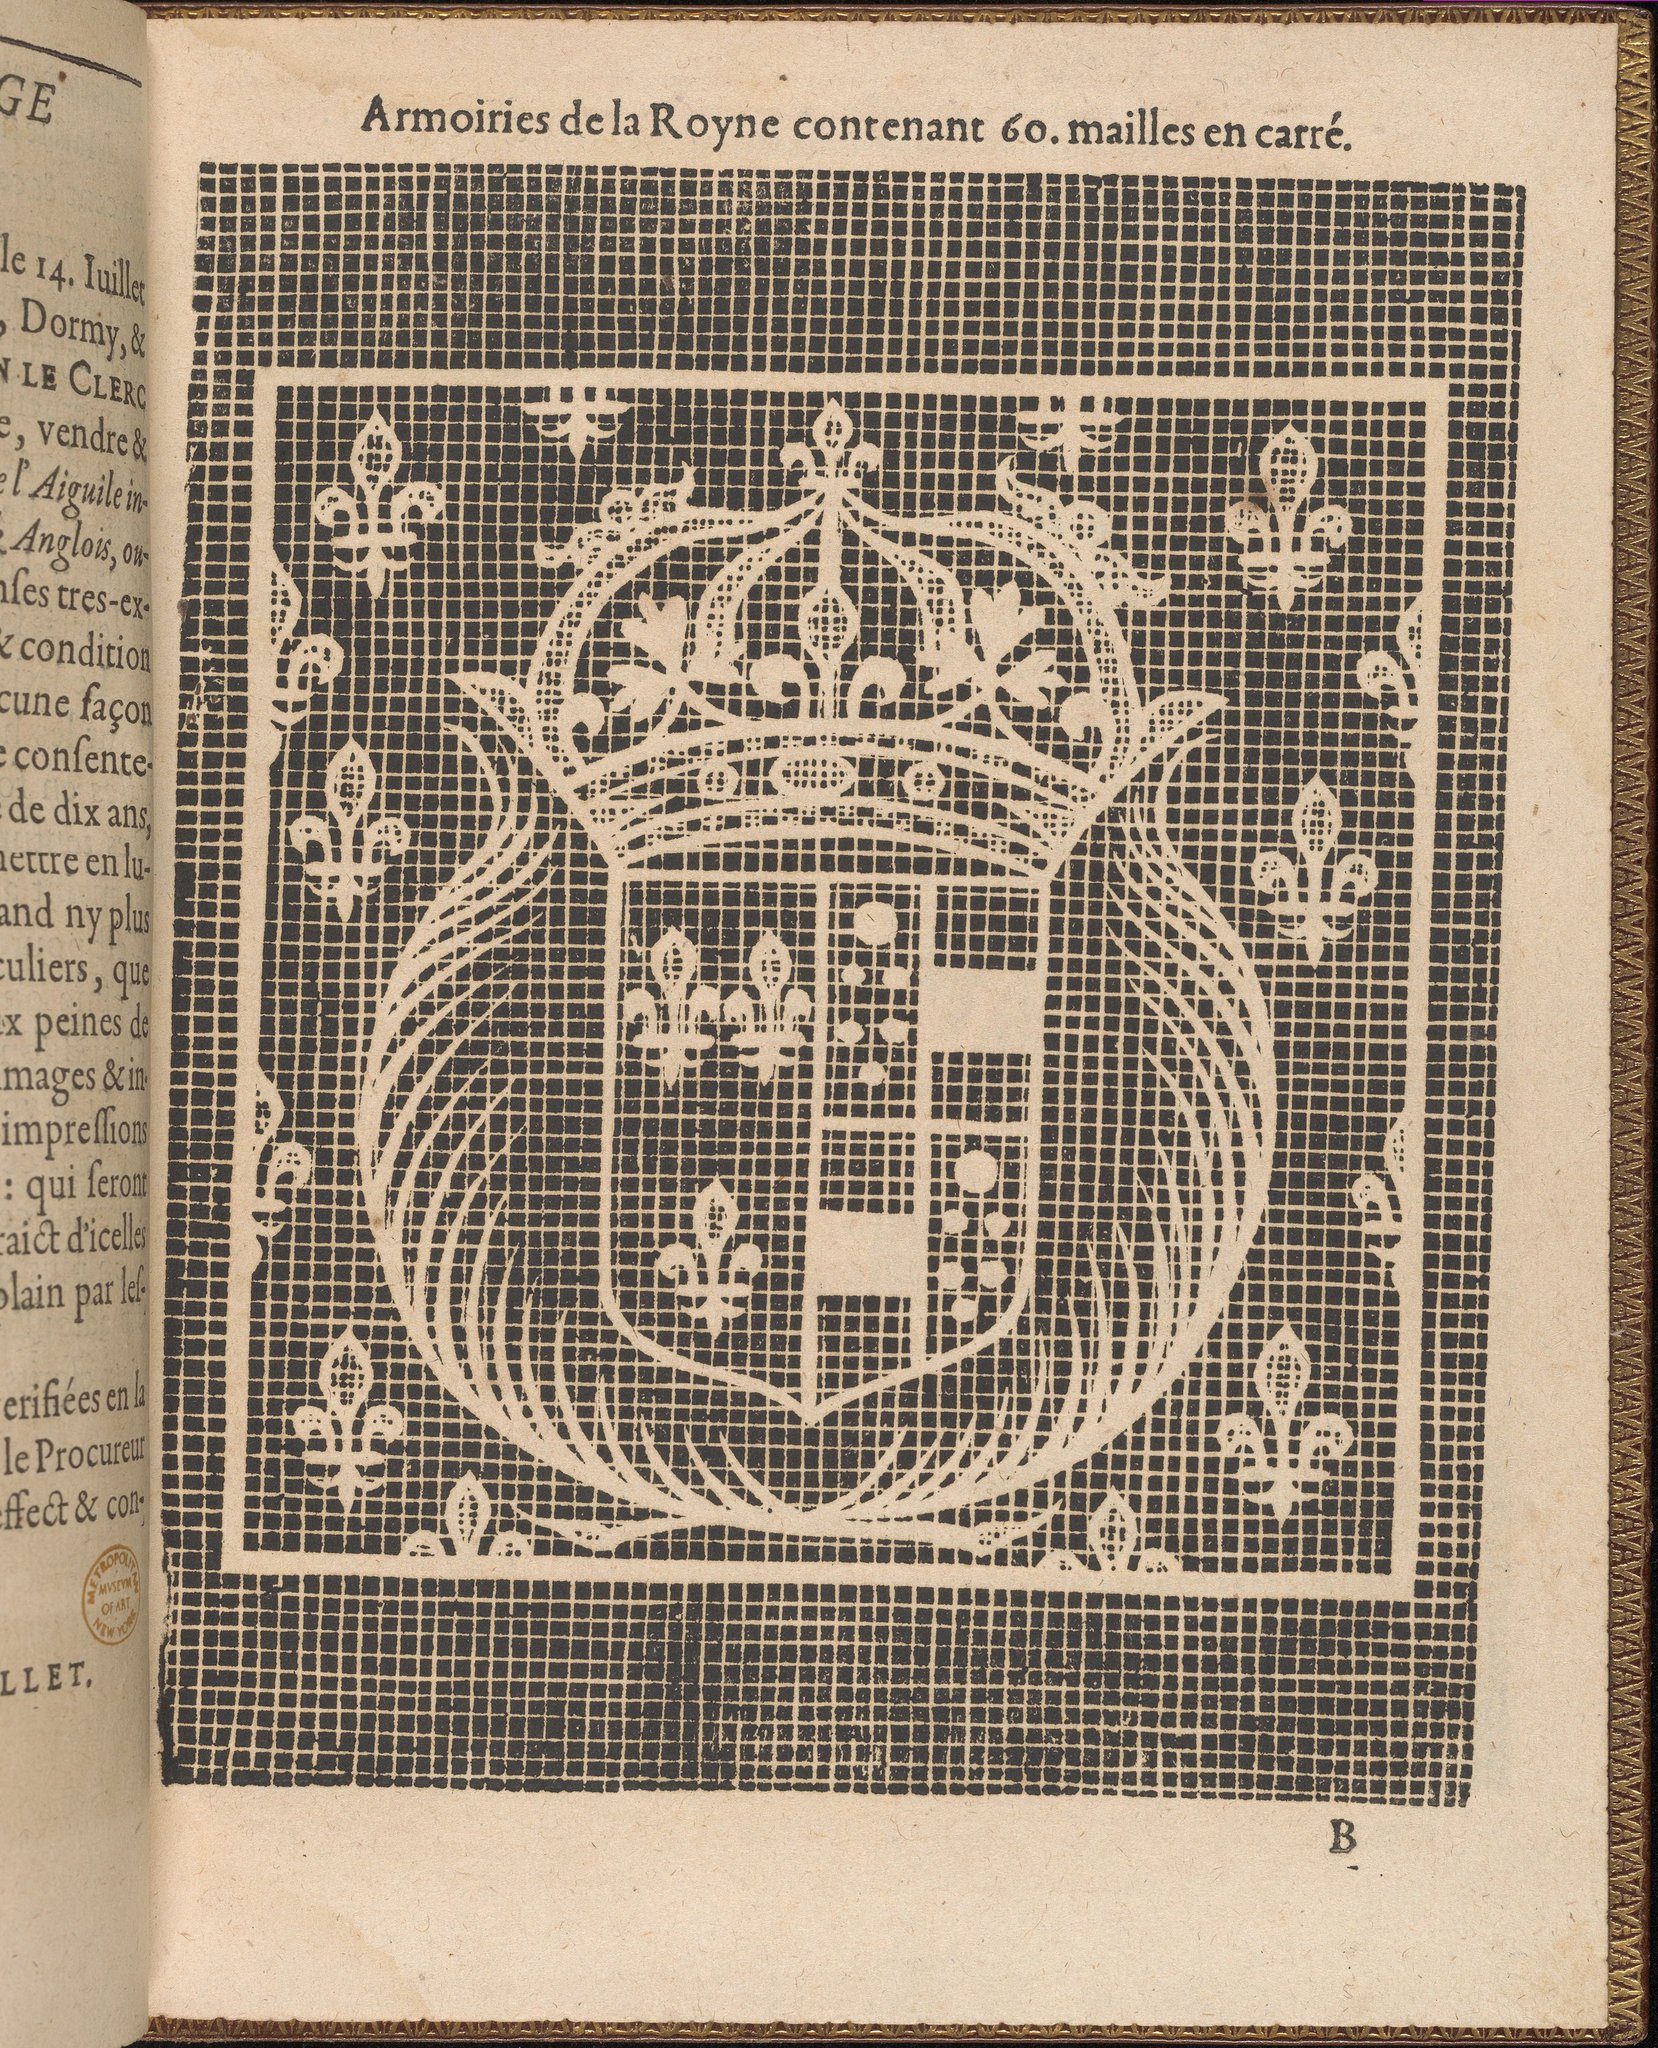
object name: book print ornament architecture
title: La Pratique de l'Aiguille, page 5 (recto)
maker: matthias mignerak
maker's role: author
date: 1605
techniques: woodcut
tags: coat of arms